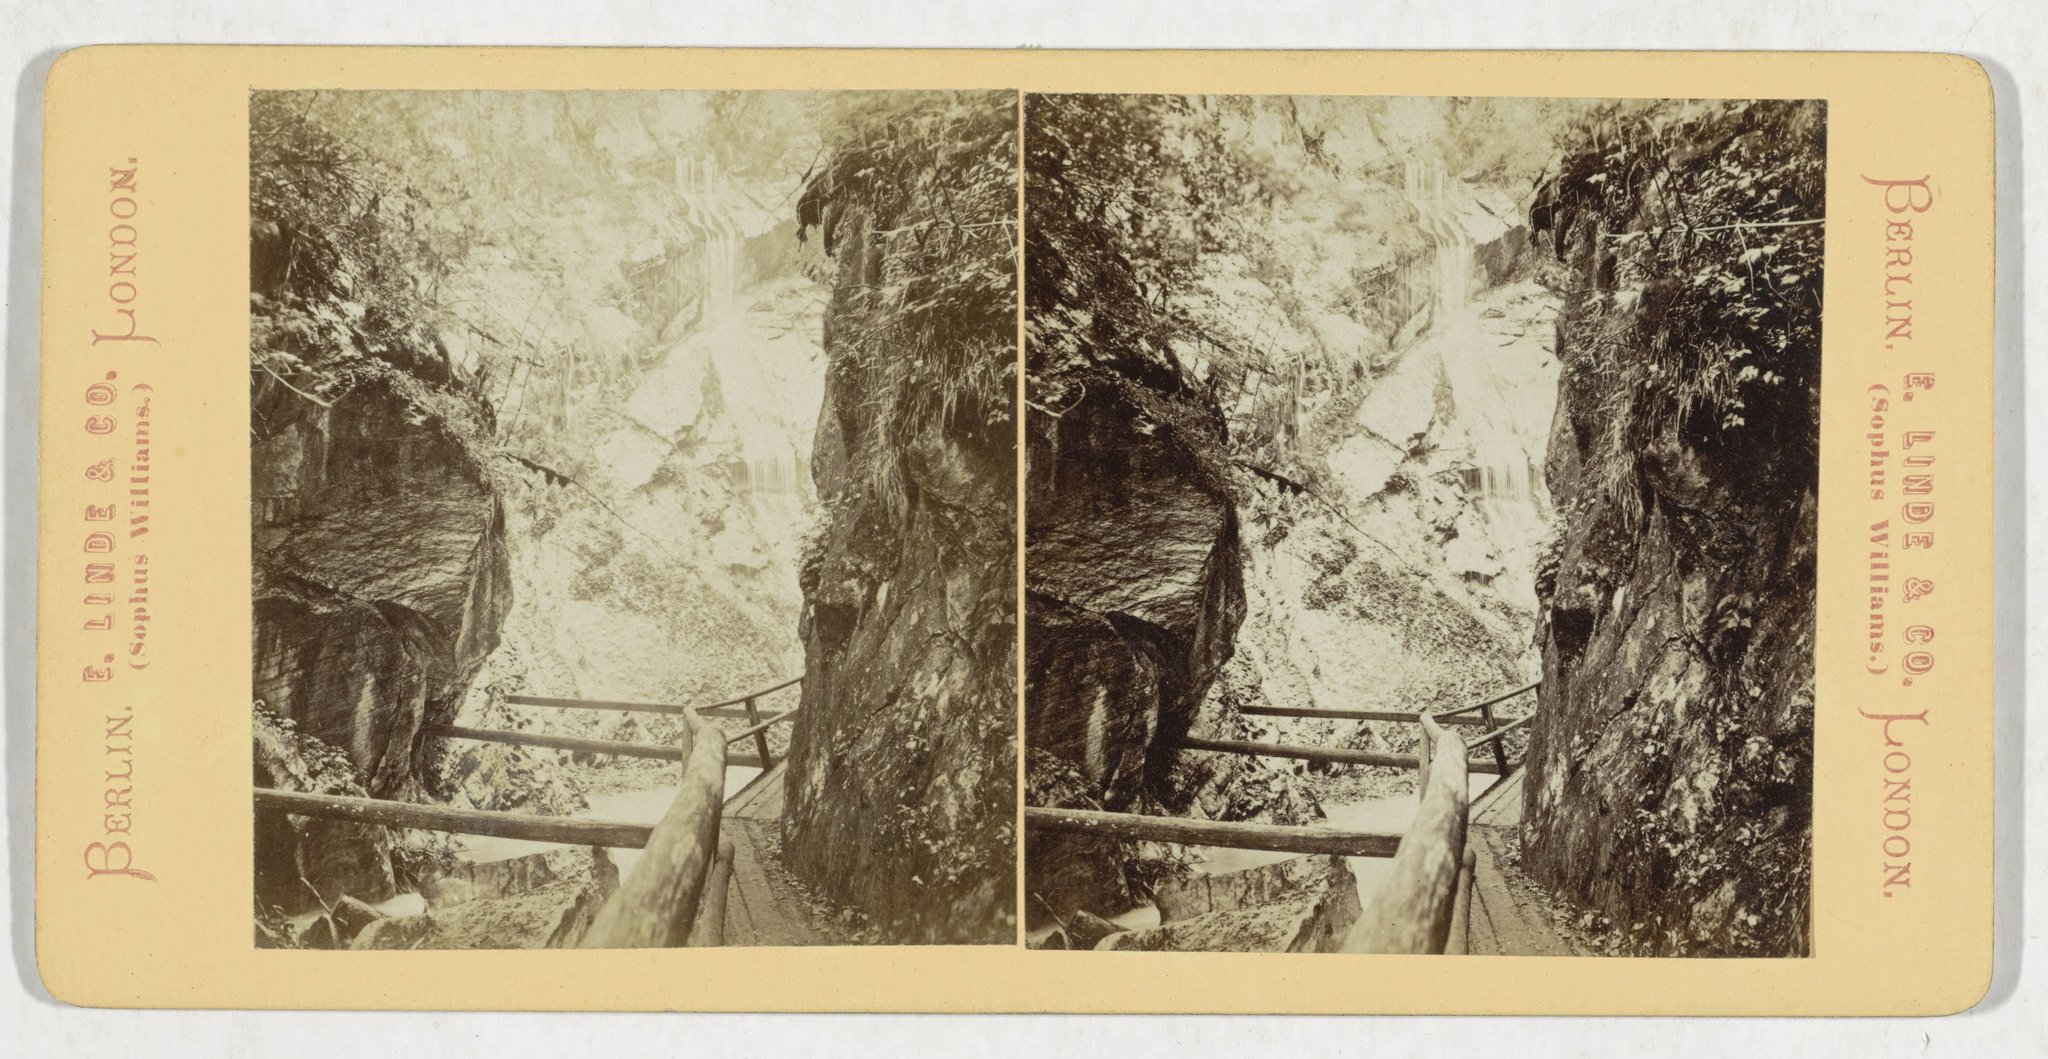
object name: stereograph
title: Wimbachklamm in Ramsau bei Berchtesgaden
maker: Anonymous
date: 1868-1890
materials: cardboard, paper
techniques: albumen print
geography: berlin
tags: waterfall, ravine, chasm, abyss, canyon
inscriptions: number: ‘No 28.’